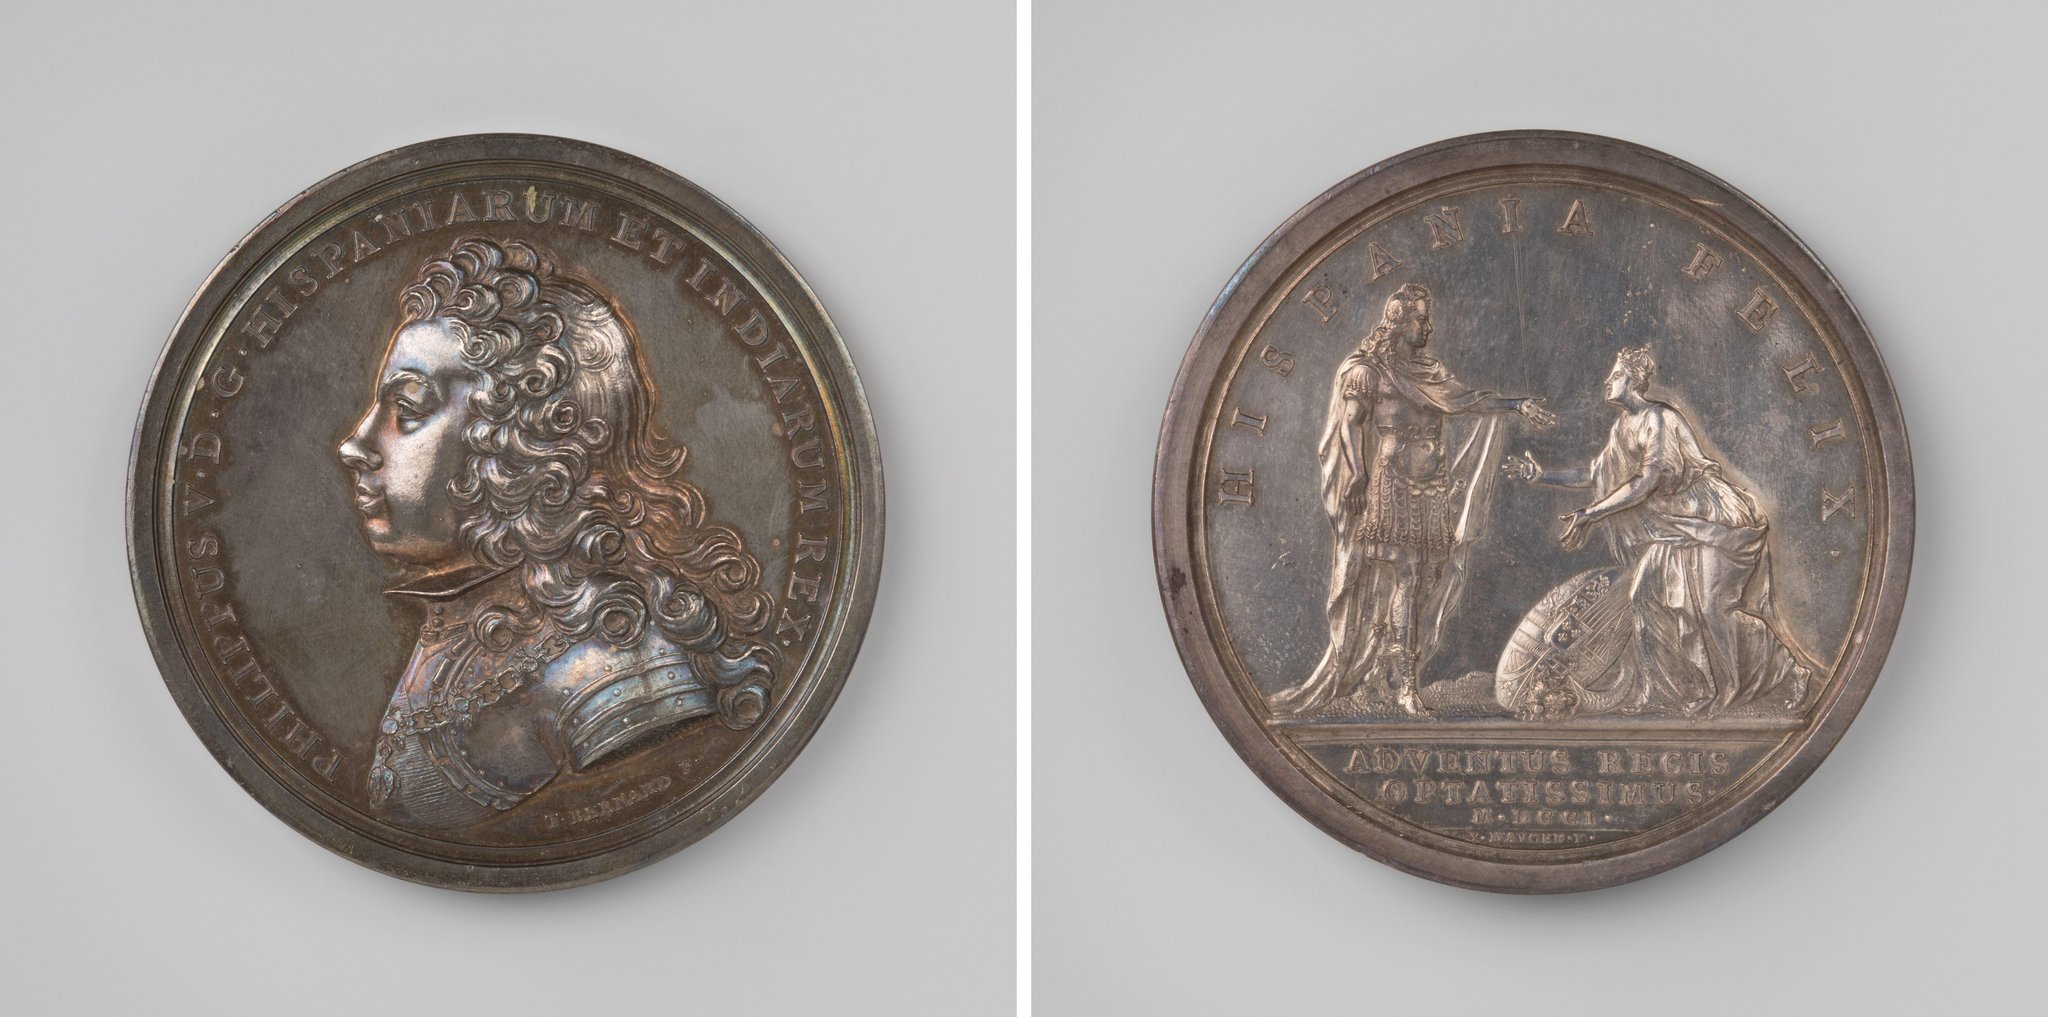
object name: history medal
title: Intrede van Filips V, koning van Spanje te Madrid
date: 1699-1703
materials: silver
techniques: striking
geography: paris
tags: filips v (koning van spanje), spain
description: Zilveren penning. Voorzijde: borststuk man binnen omschrift. Keerzijde: de nieuwe koning, in Romeinse kledij, wordt door het Spaanse rijk, afgebeeld als een knielende vrouw ontvangen binnen omschrift, boven opschrift.